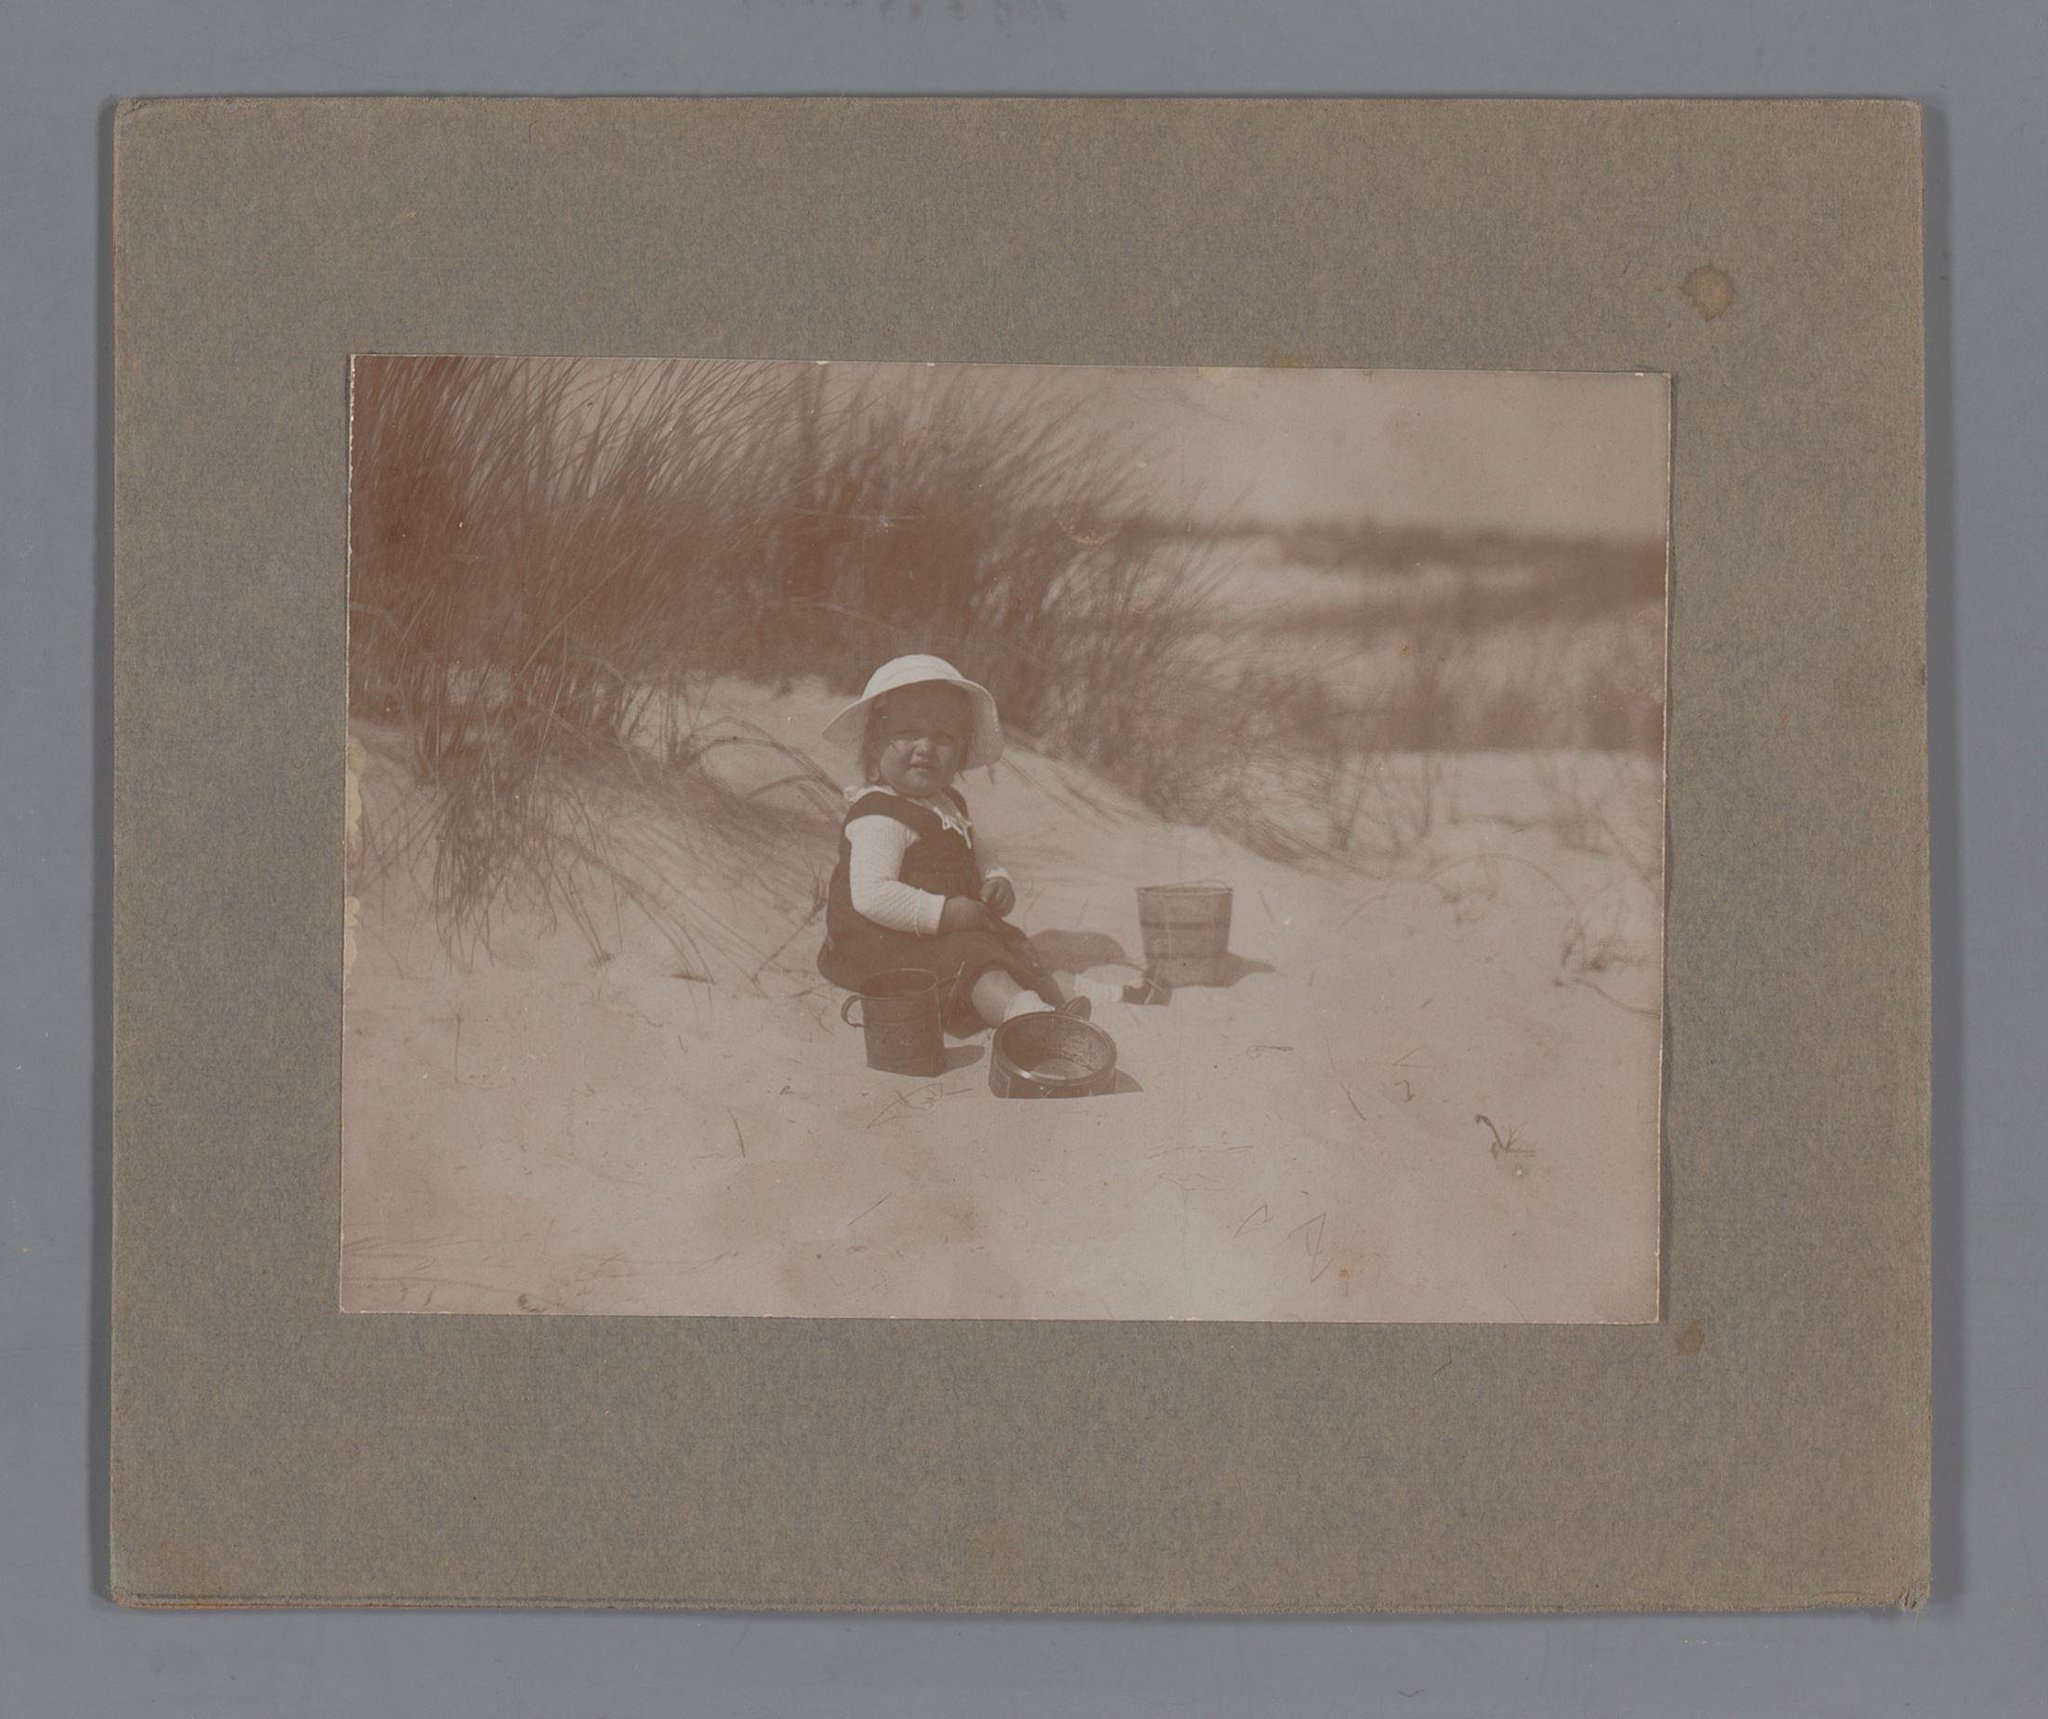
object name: photograph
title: Portret van Jacobus Cornelis van der Waals in de duinen te Bergen aan Zee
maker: johannes diderik van der waals (1873-1971)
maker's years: 1873-1971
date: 1912-1920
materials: cardboard, photographic support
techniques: collodion silver print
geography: bergen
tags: historical persons, dunes (sea not visible); in the dunes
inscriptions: annotation: ‘kees v/d Waals/ in Bergen aan Zee’